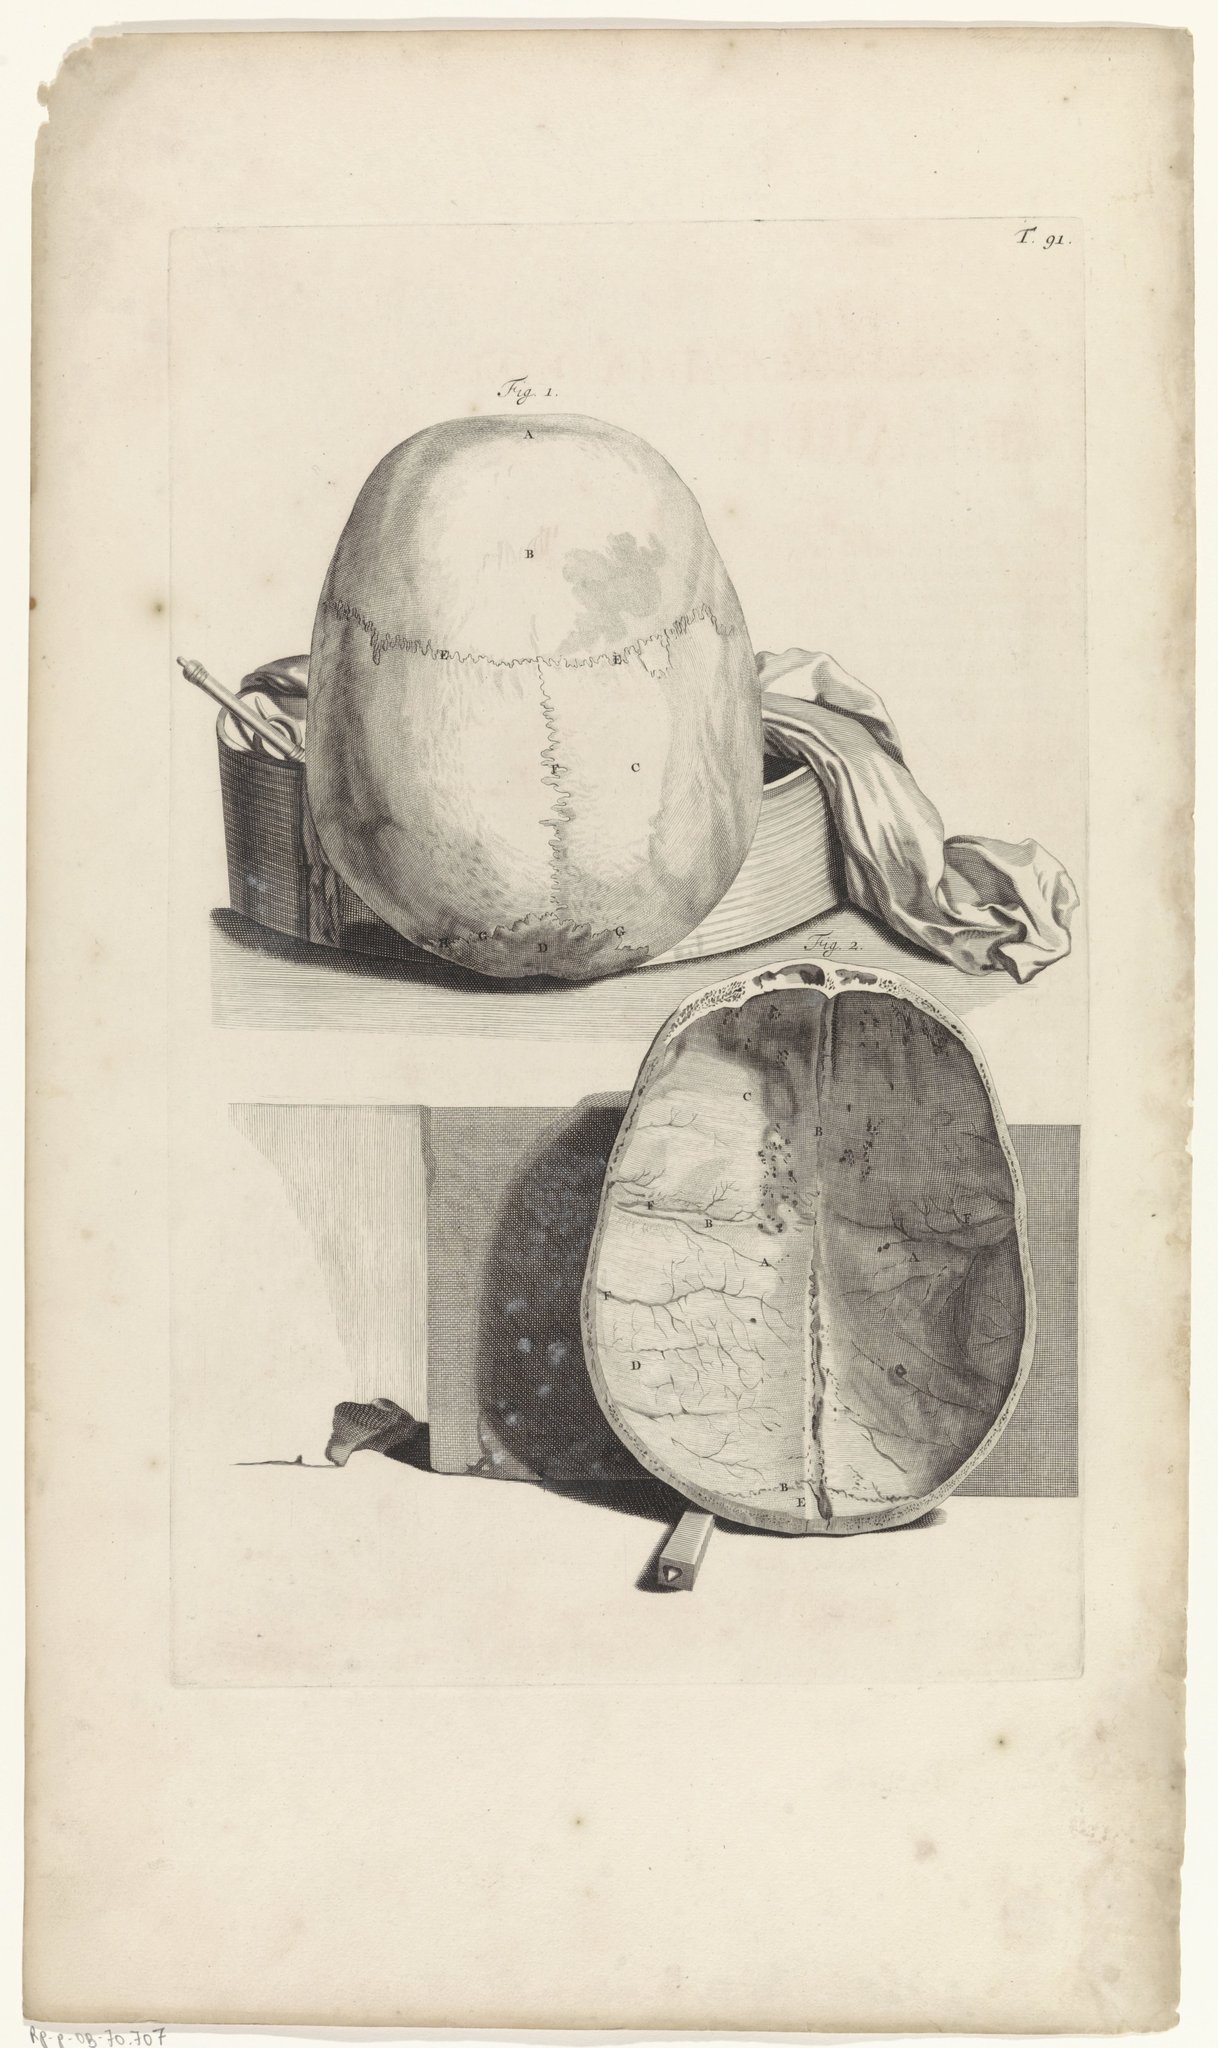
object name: book illustration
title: Anatomische studie van de schedelpan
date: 1685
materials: paper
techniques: engraving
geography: amsterdam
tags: (human) skull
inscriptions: collector's mark: Lugt 2228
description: Boekillustratie voor Bidloo, Godefridus. Anatomia humani corporis centum & quinque tabulis, per art. G. de Lairesse ad vivum delineatis, de monstrata, veterum recentiorumque inventis explicata plurimisque, hactenus non detectis, illustrata. Amsterdam: Weduwe Joannes van Someren, Hendrick Boom en erven Dirk Boom, 1685.